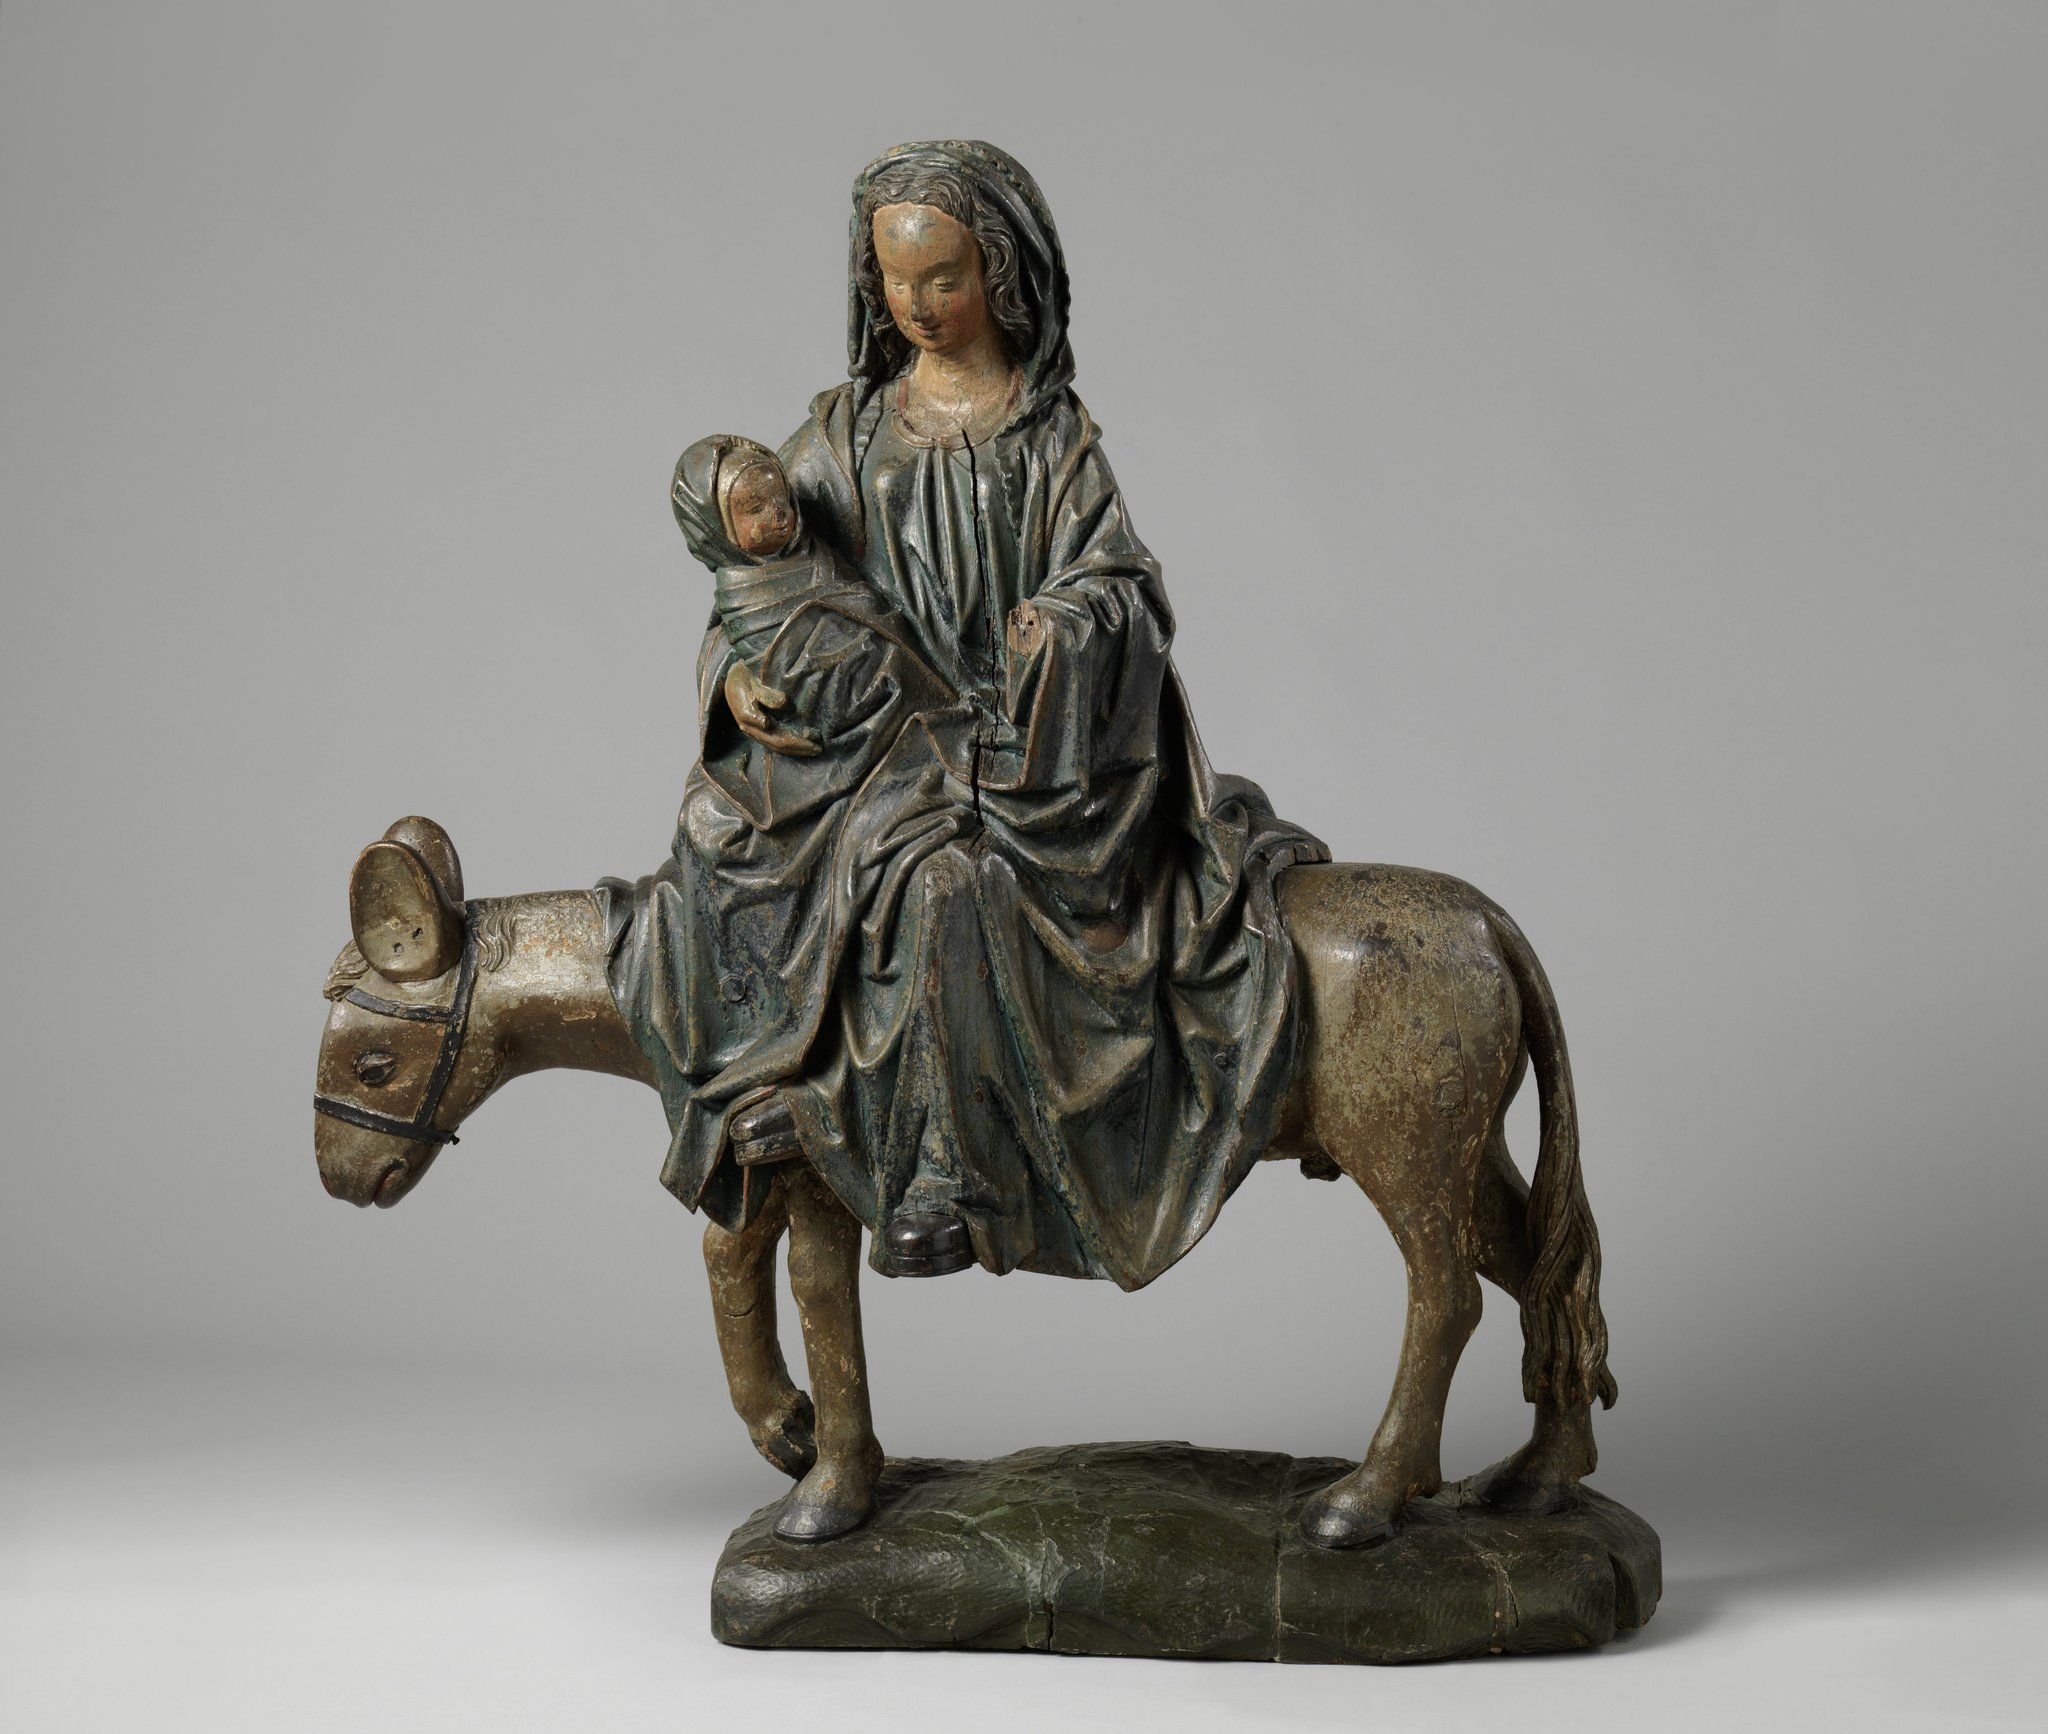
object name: sculpture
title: Flight into Egypt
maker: Anonymous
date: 1500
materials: wood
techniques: polychromy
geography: northern netherlands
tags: the flight into egypt: mary, joseph, the child (and sometimes others) on their way; mary usually riding on an ass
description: The Flight into Egypt. Oak with later polychromy. Utrecht, c. 1500.